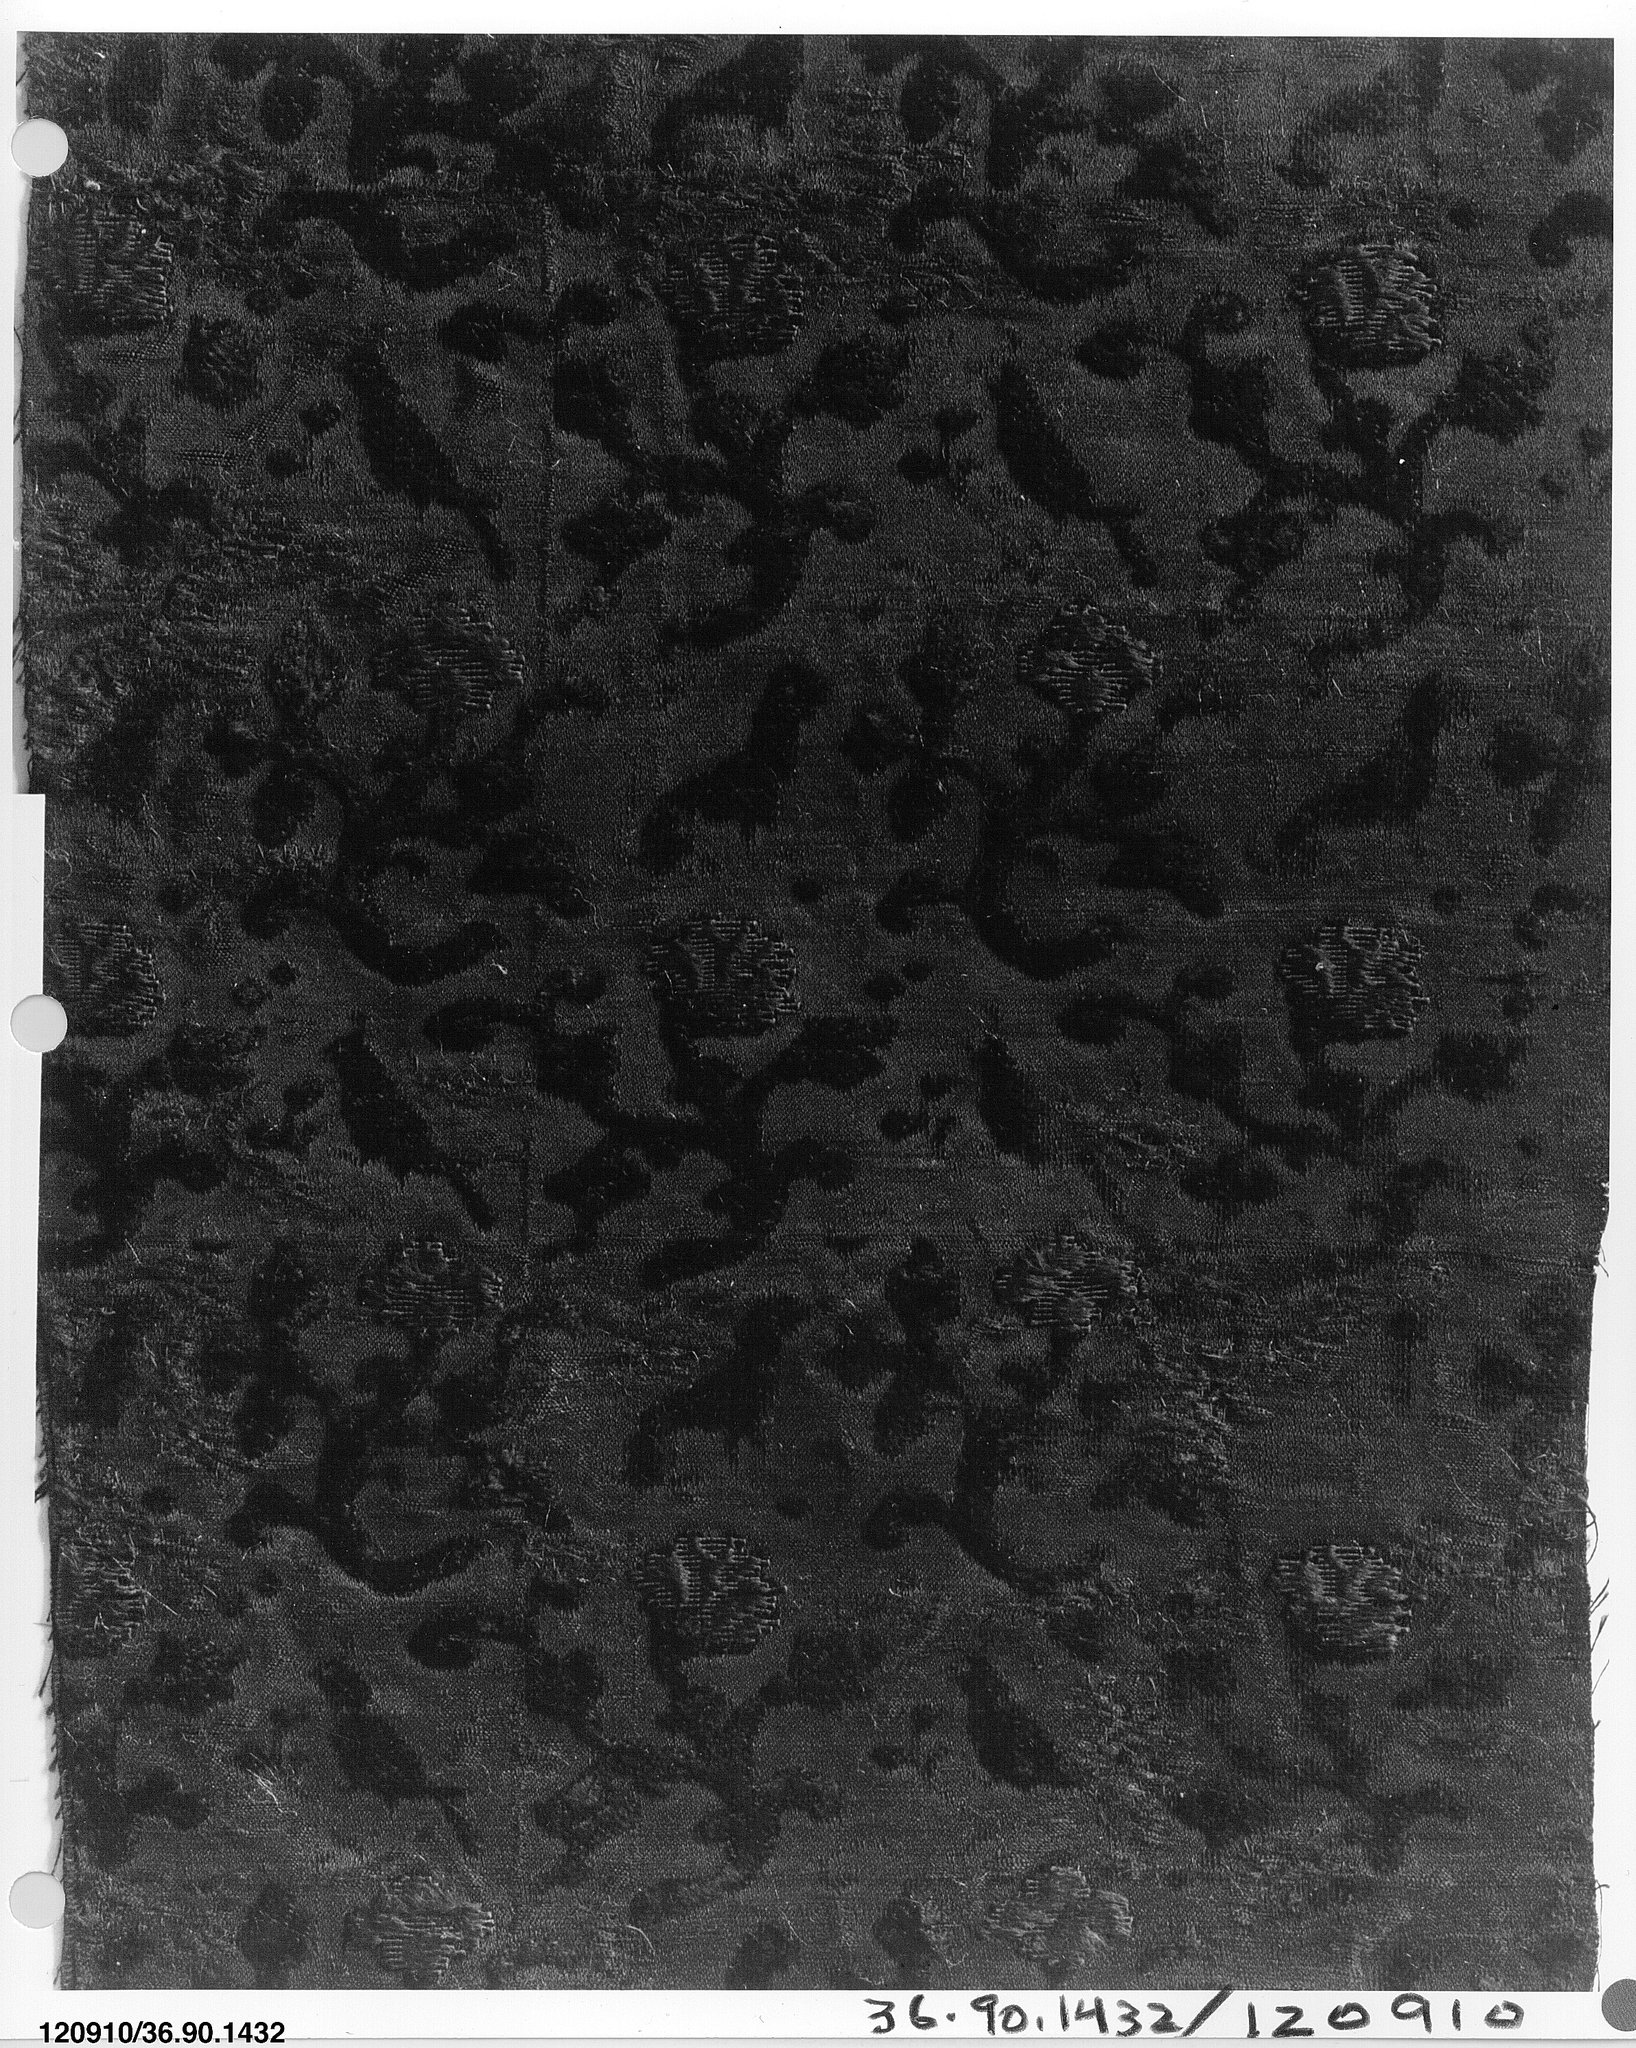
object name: piece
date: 1601-1700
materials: silk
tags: birds,leaves